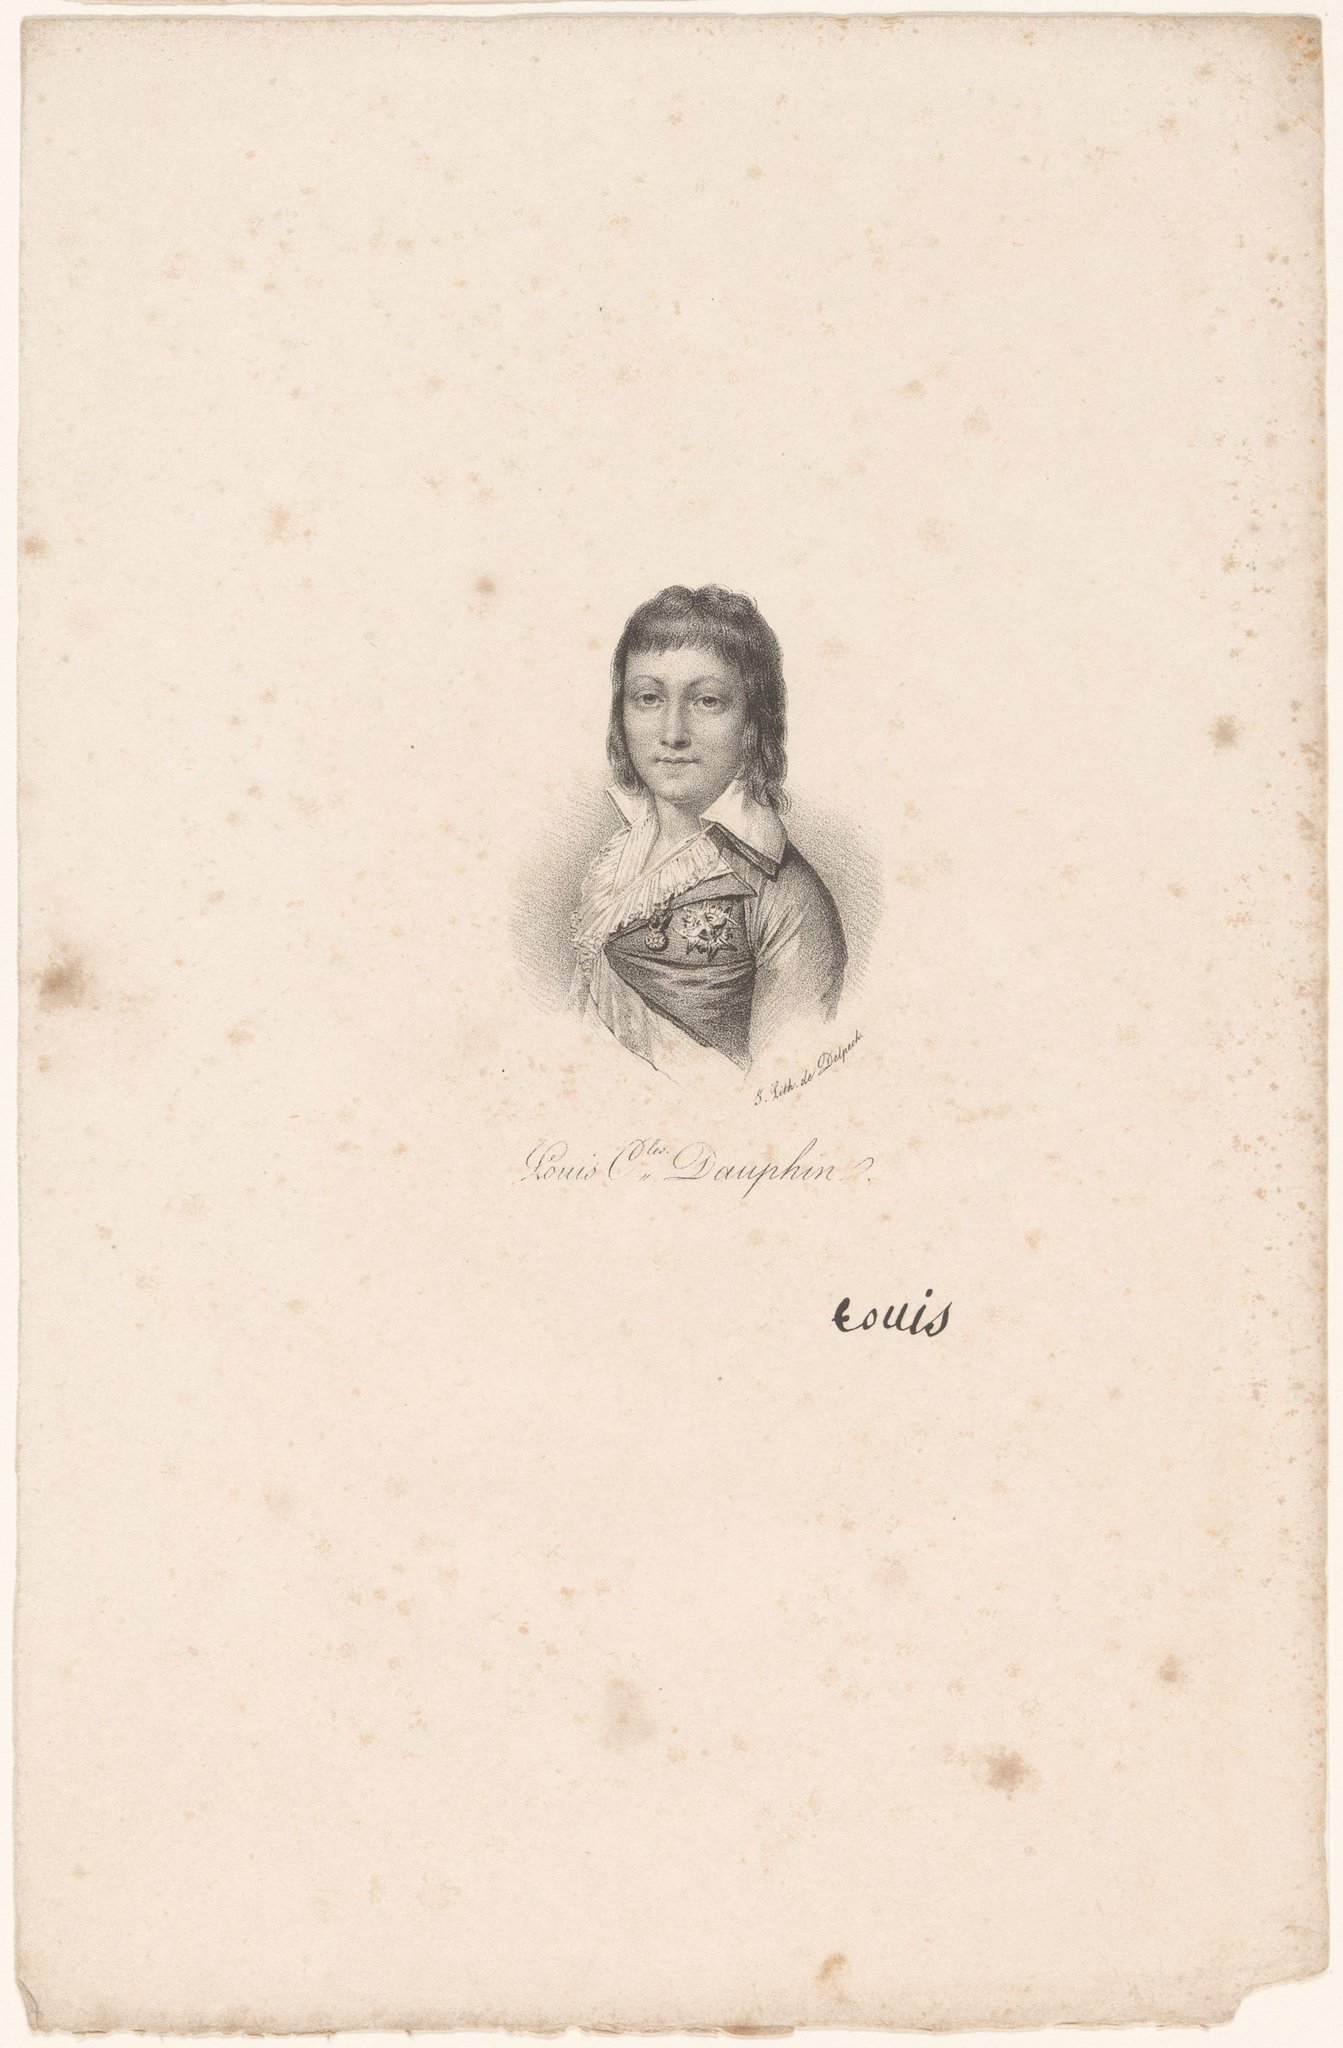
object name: print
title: Portret van Lodewijk XVII van Frankrijk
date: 1818-1842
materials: paper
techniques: lithograph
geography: paris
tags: historical persons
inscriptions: collector's mark: Lugt 2228a